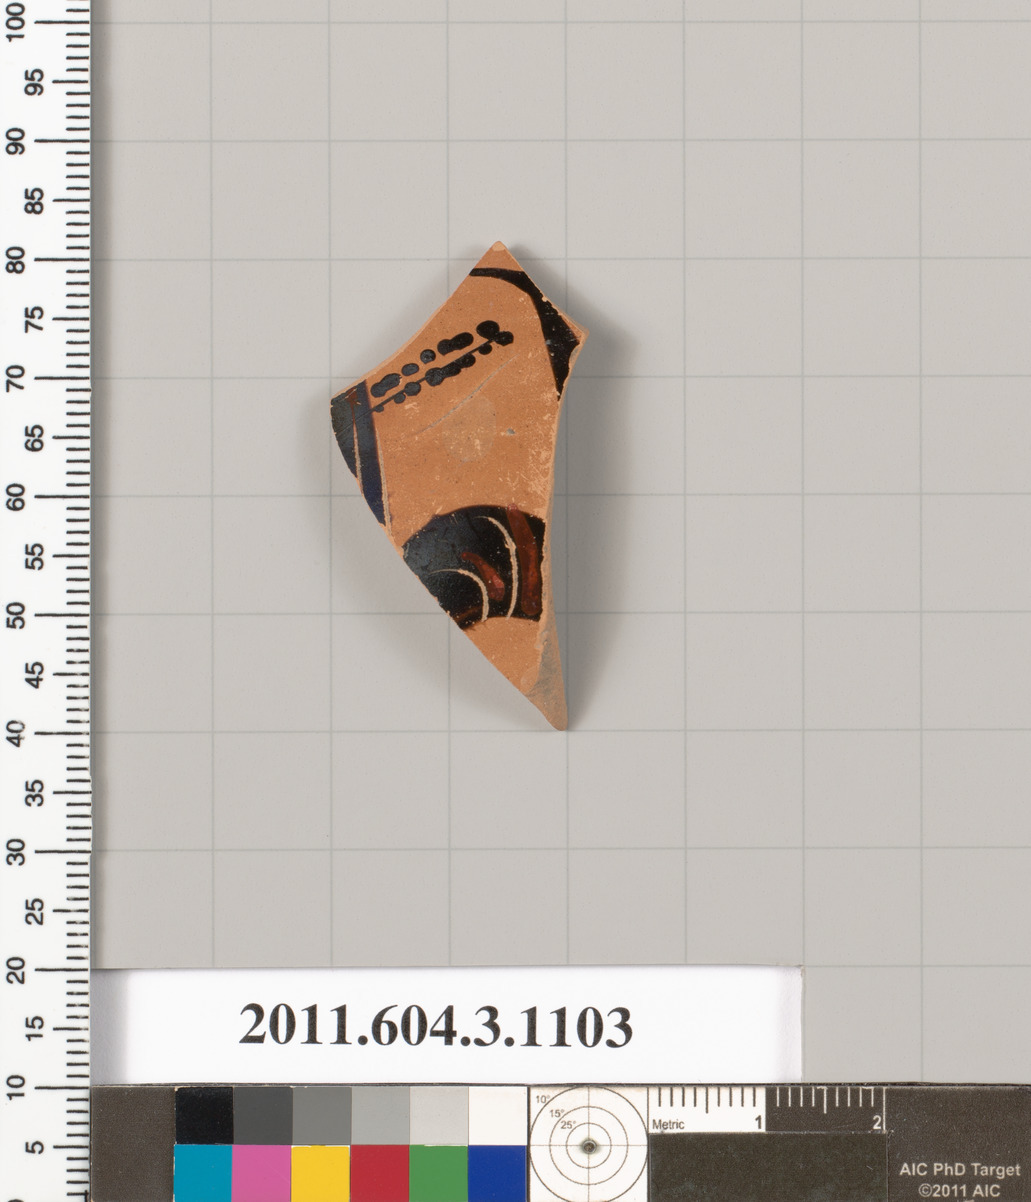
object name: mastoid or kyathos fragment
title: Terracotta fragment of a mastoid (drinking cup with narrow base) or a kyathos (cup-shaped ladle)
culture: greek, attic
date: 534-468 BCE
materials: terracotta